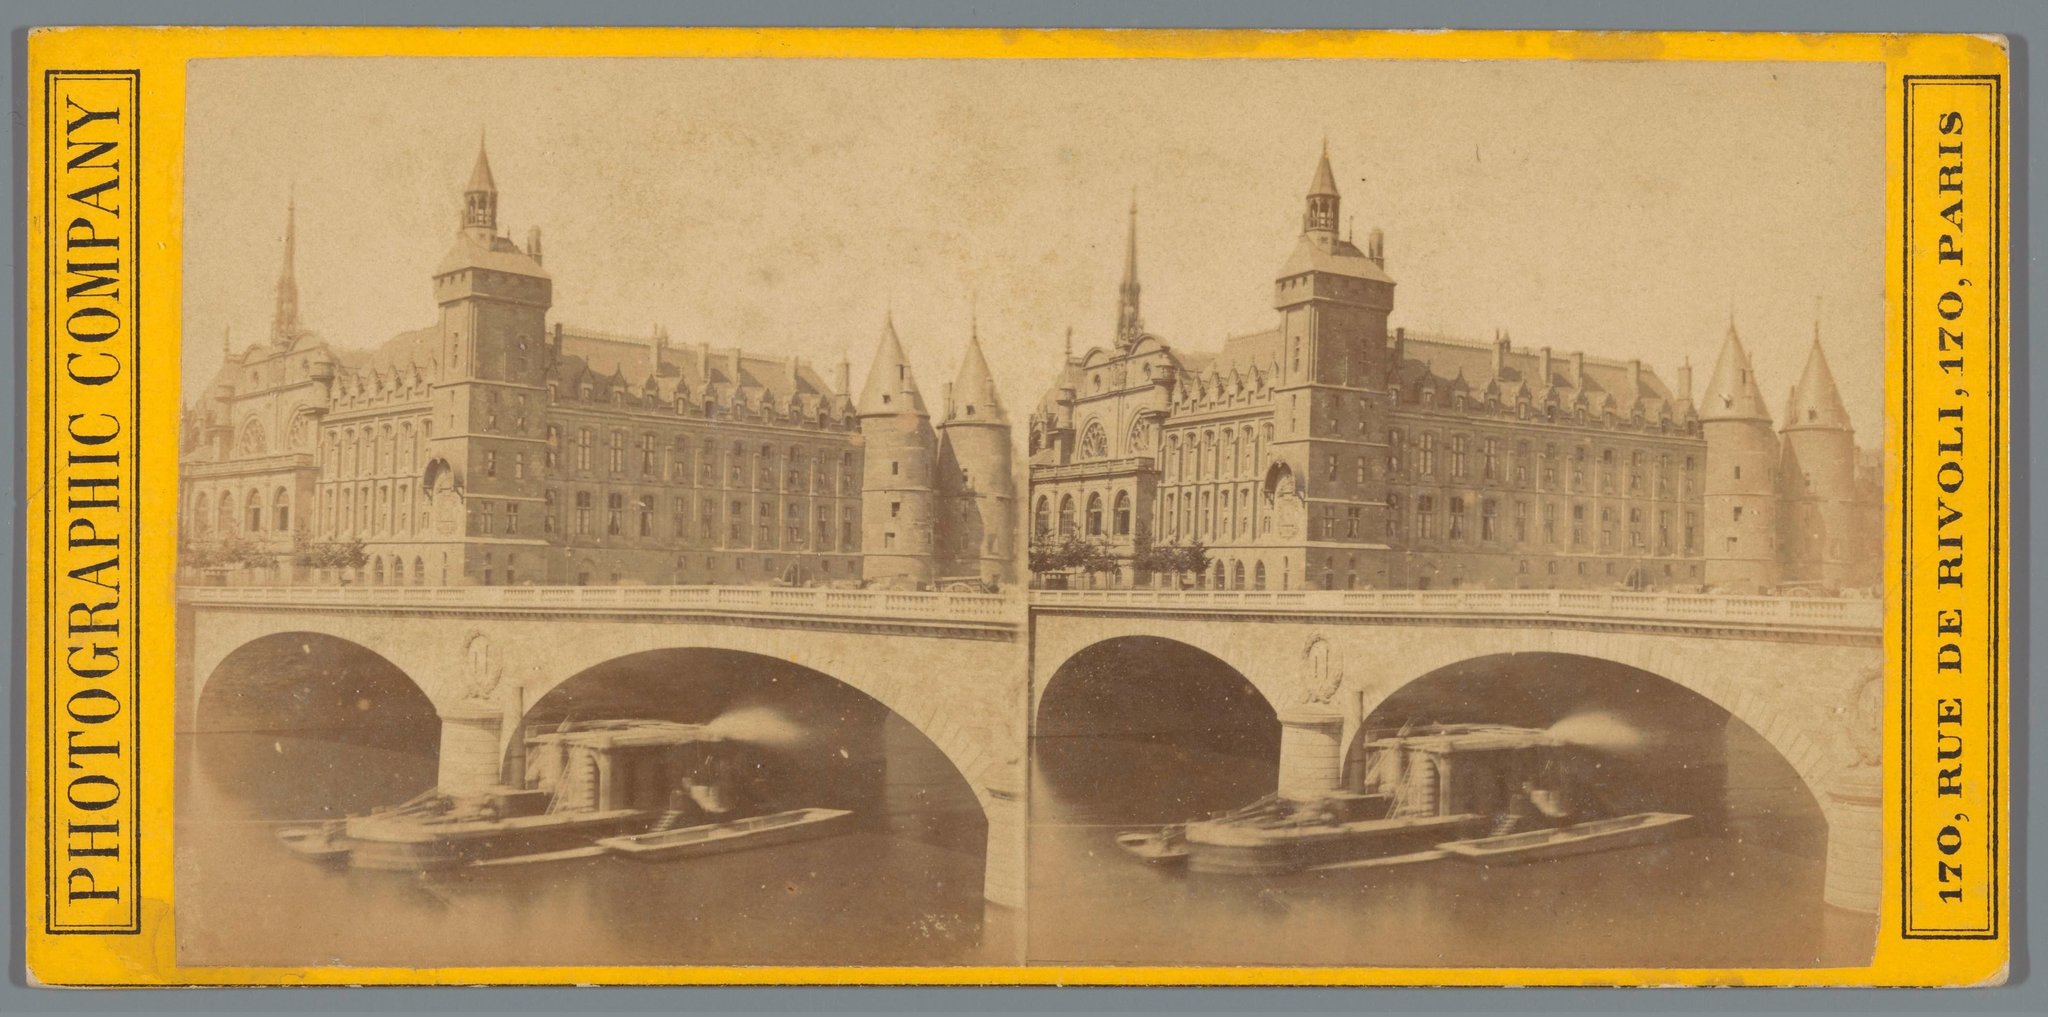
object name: stereograph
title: Gezicht op La Conciergerie en de Pont au Change in Parijs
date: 1860-1880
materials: cardboard, photographic support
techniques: albumen print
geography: paris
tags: bridge in city across river, canal, etc.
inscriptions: inscription: ‘Palais de Justice et Conciergerie Pont au Change (sur [...]’